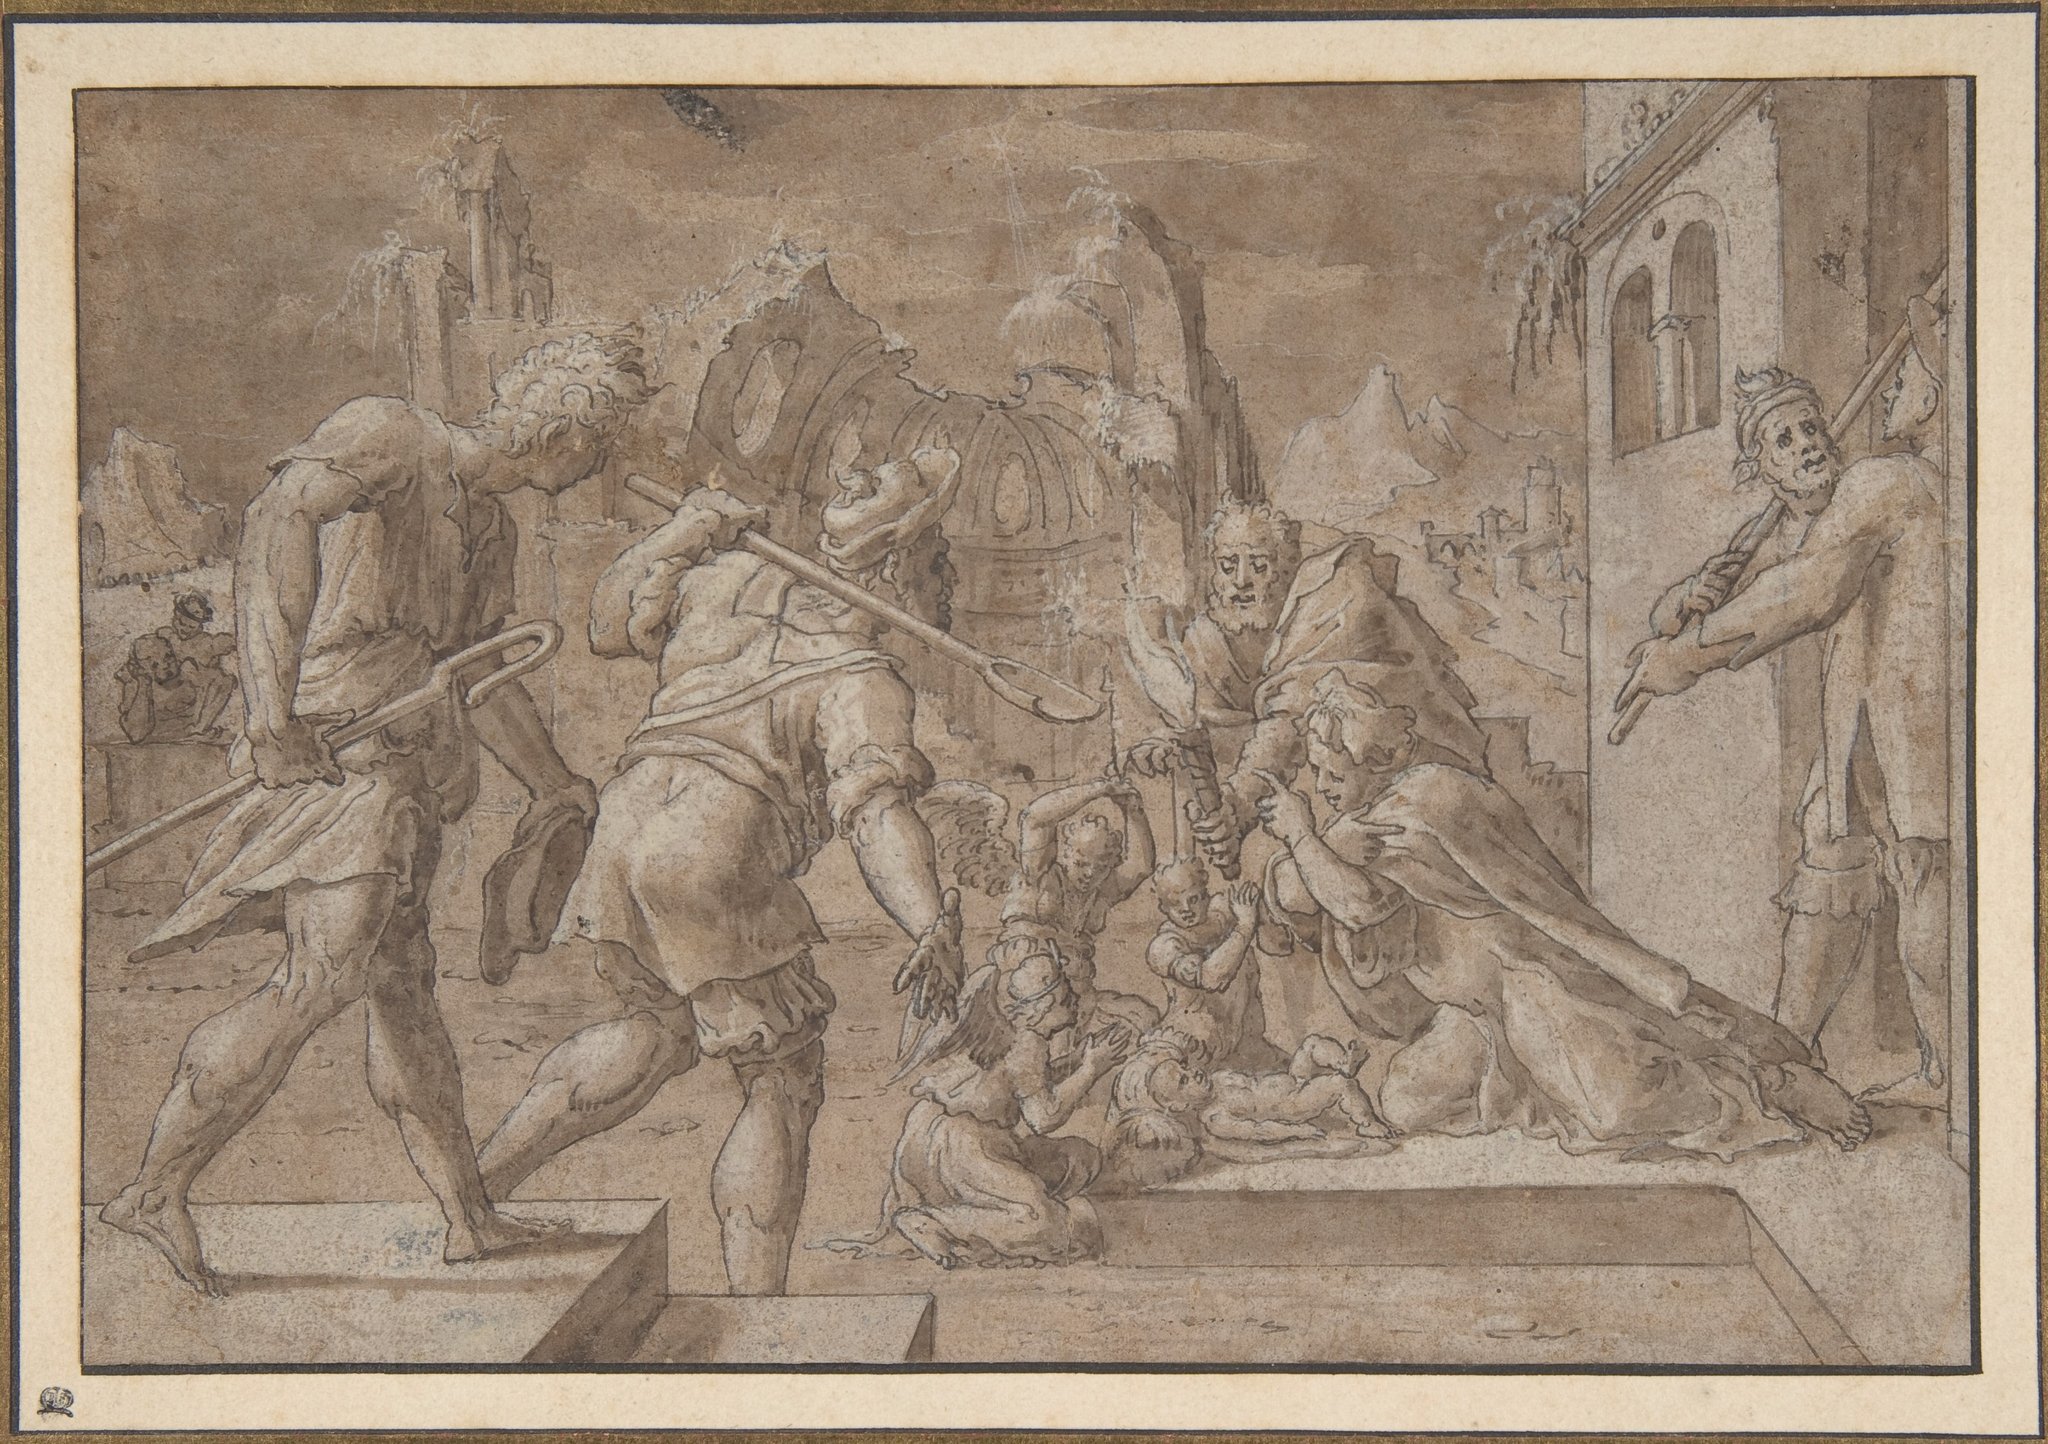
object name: drawing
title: Adoration of the Shepherds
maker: master of liechtenstein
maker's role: artist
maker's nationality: netherlandish (?)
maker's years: 1549-1550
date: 1549-1550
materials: gouache, ink, paper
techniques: pen, wash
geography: liechtenstein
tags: weapons,men,angels,adoration of the shepherds